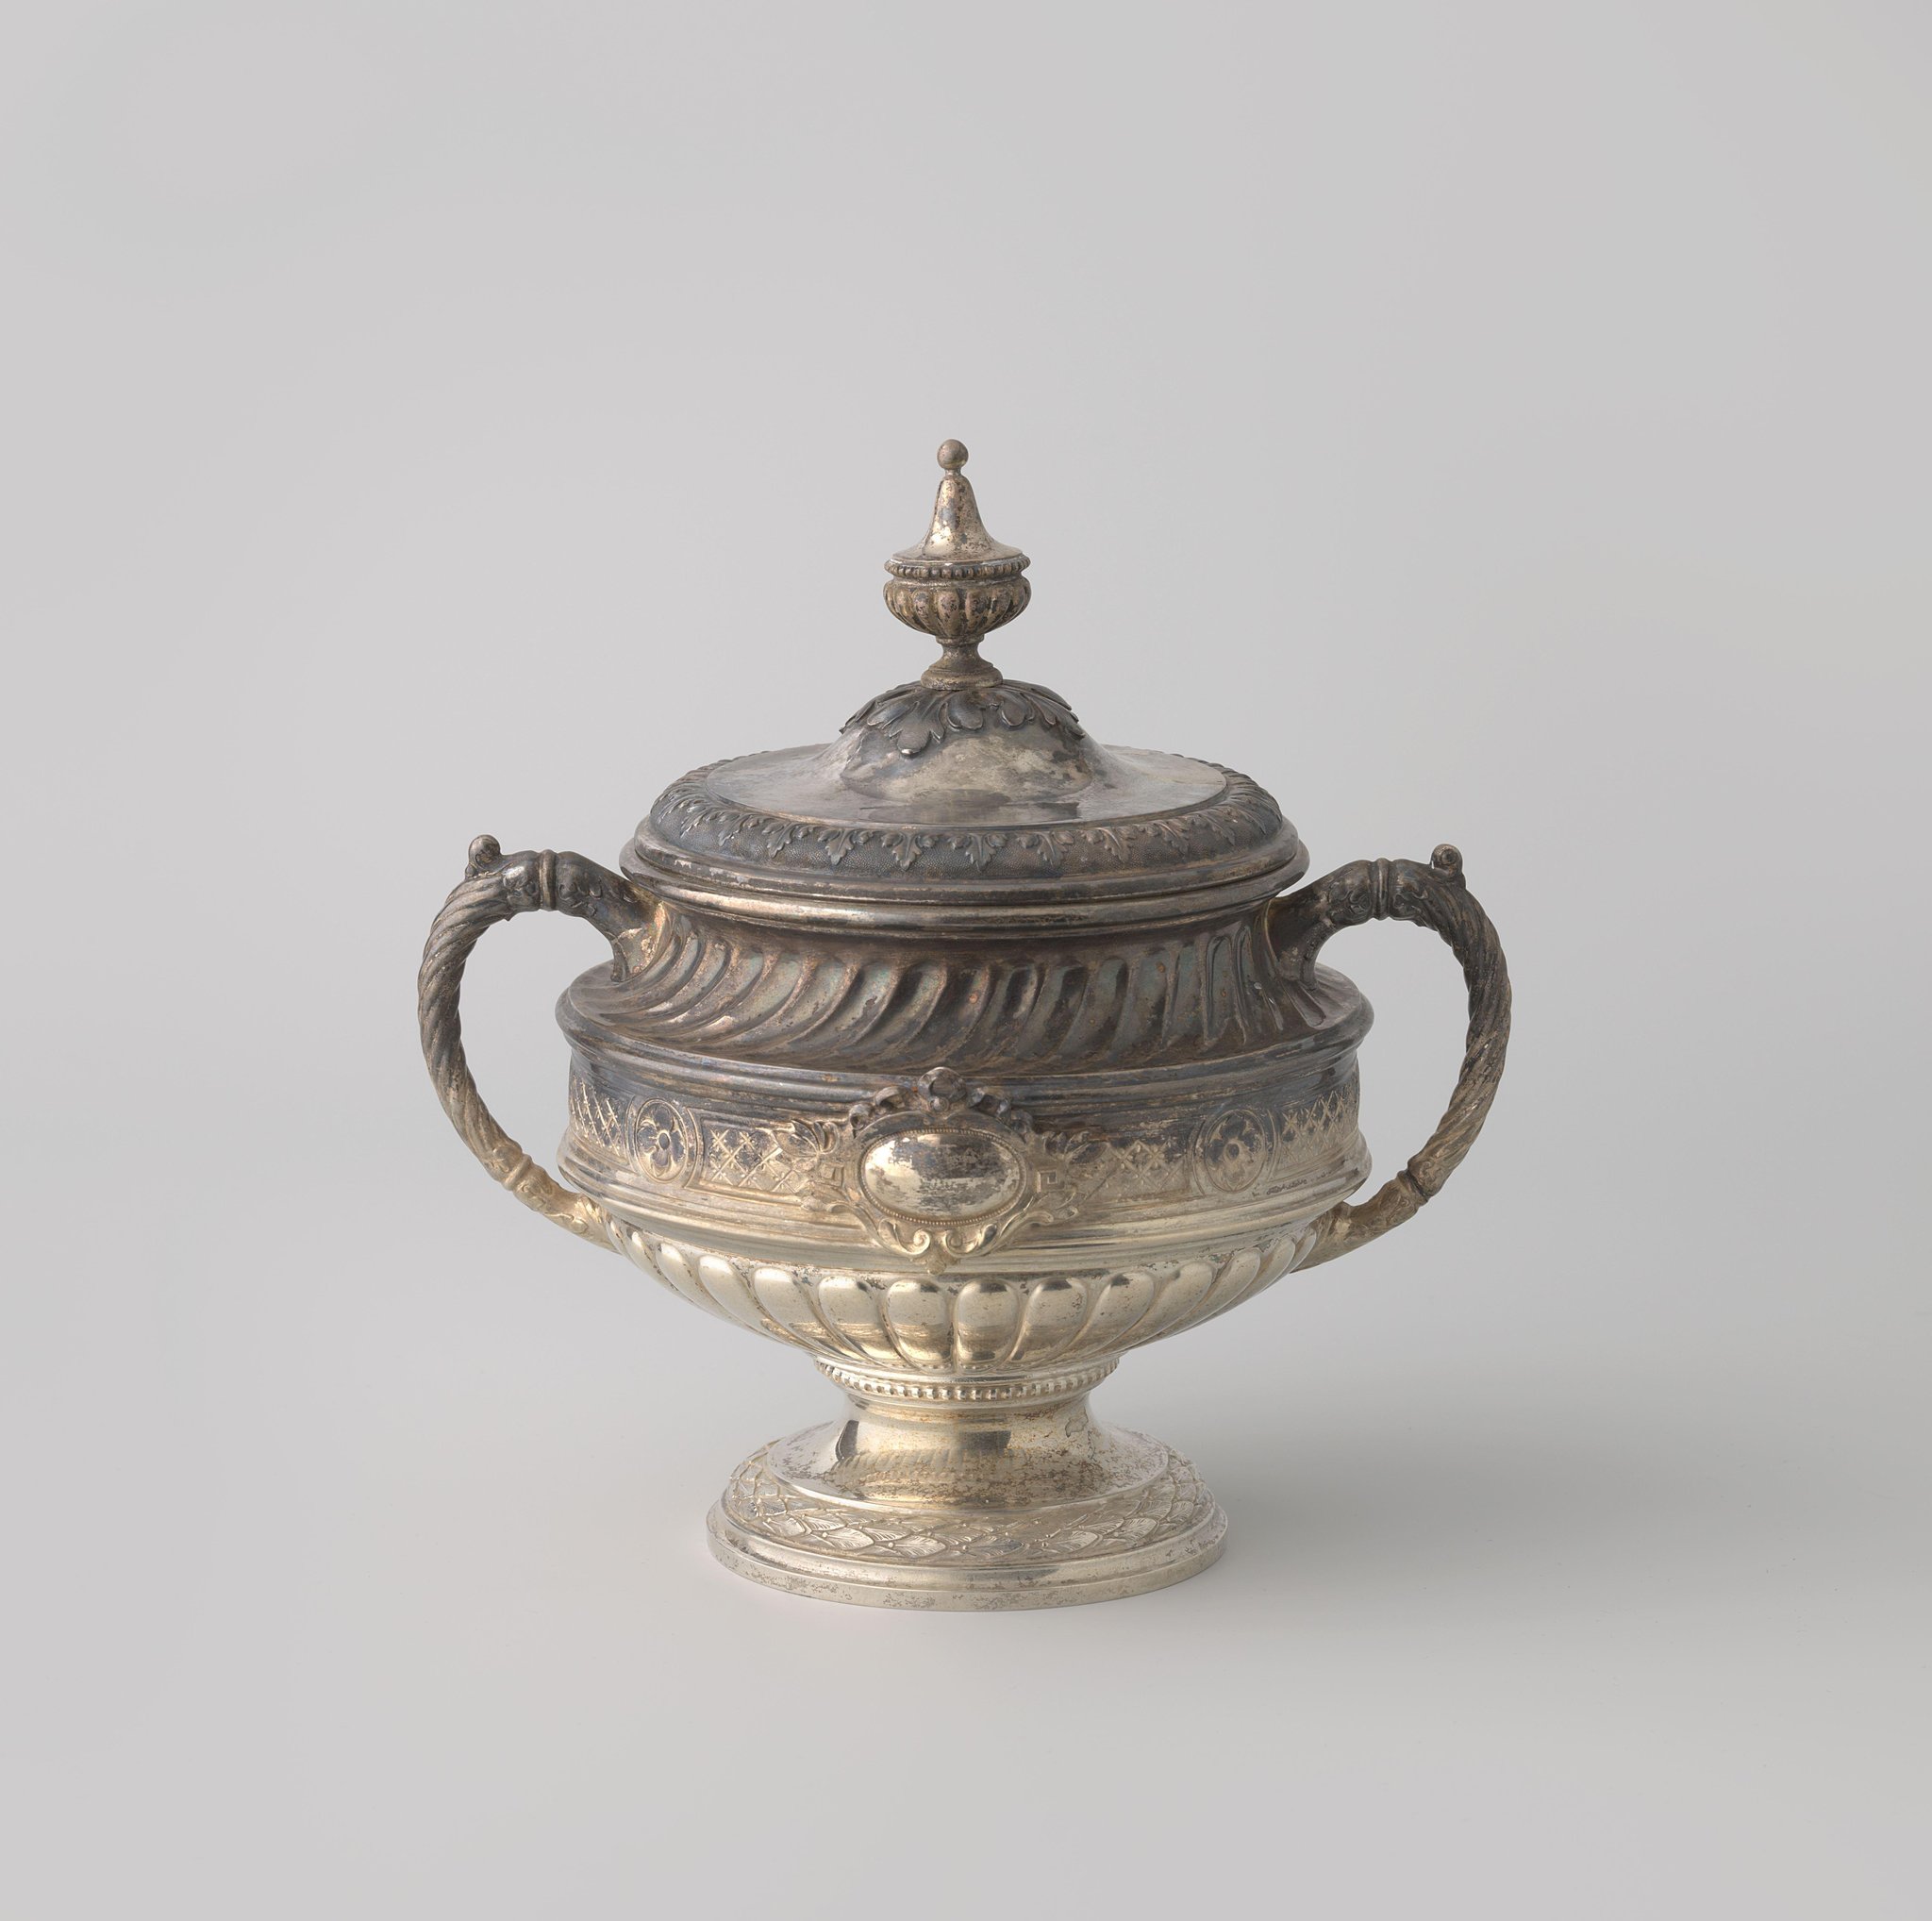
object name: sugar box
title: Suikerpot met deksel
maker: Anonymous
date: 1888-1906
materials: silver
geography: germany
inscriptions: mark: ‘24006, 800, halve maan en keizerskroon,’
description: Suikerpot op een hoge uitlopende voet, met twee staande oren en een deksel. Getorste knerren op de schouder, een band met geometrische patronen en op beiden zijden een ovaal medaillon omgeven door bloem- en bandwerk in reliëf, met daarin een gekroonde W en in de W ook de letters 'BONE' en het jaartal 1894. De klokvormige deksel wordt bekroond door een urnvormige dekselknop.